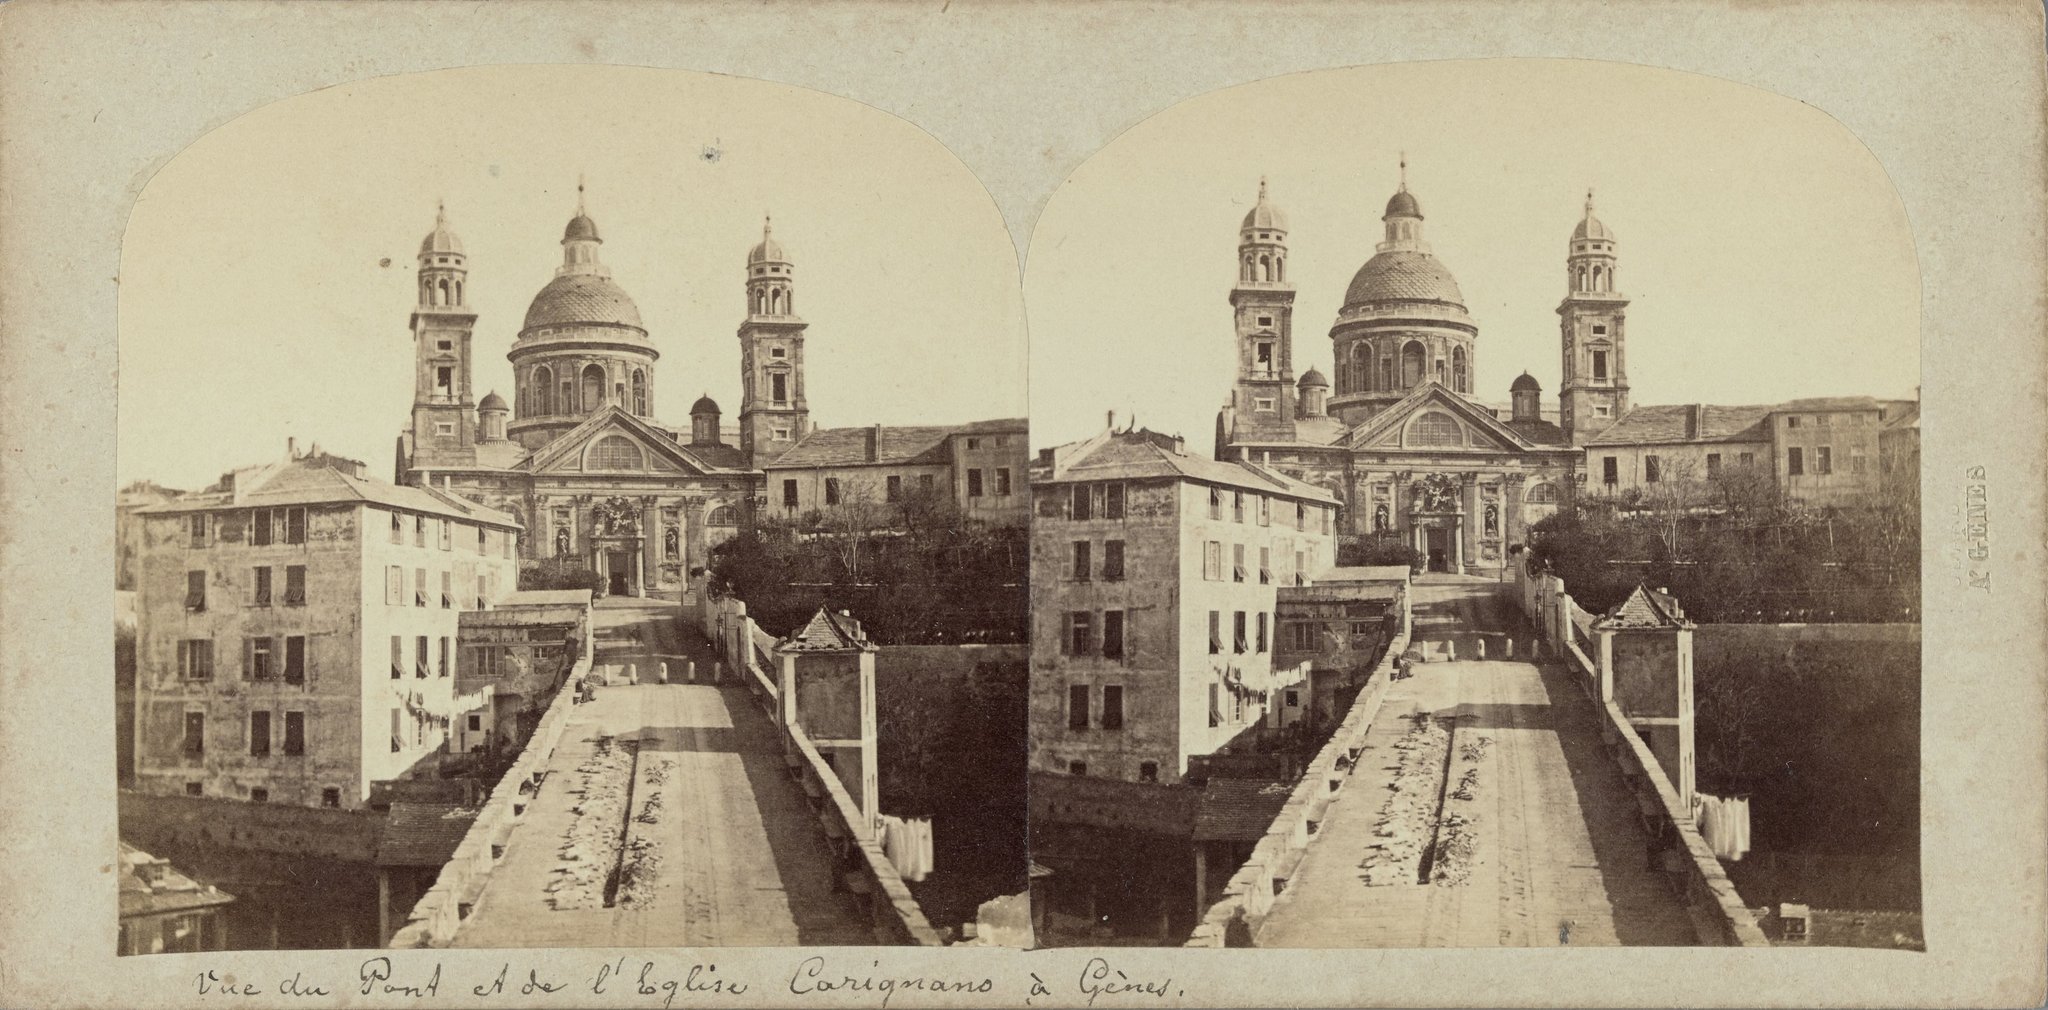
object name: stereograph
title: Vue du pont et de l'Eglise Carignano à Gènes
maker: adolphe godard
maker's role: fotograaf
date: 1860-1880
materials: cardboard, paper, photographic support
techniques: albumen print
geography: genoa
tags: church (exterior), bridge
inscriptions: inscription: ‘Genova, Carignano’, check stamp: ‘[...] a' Gènes’